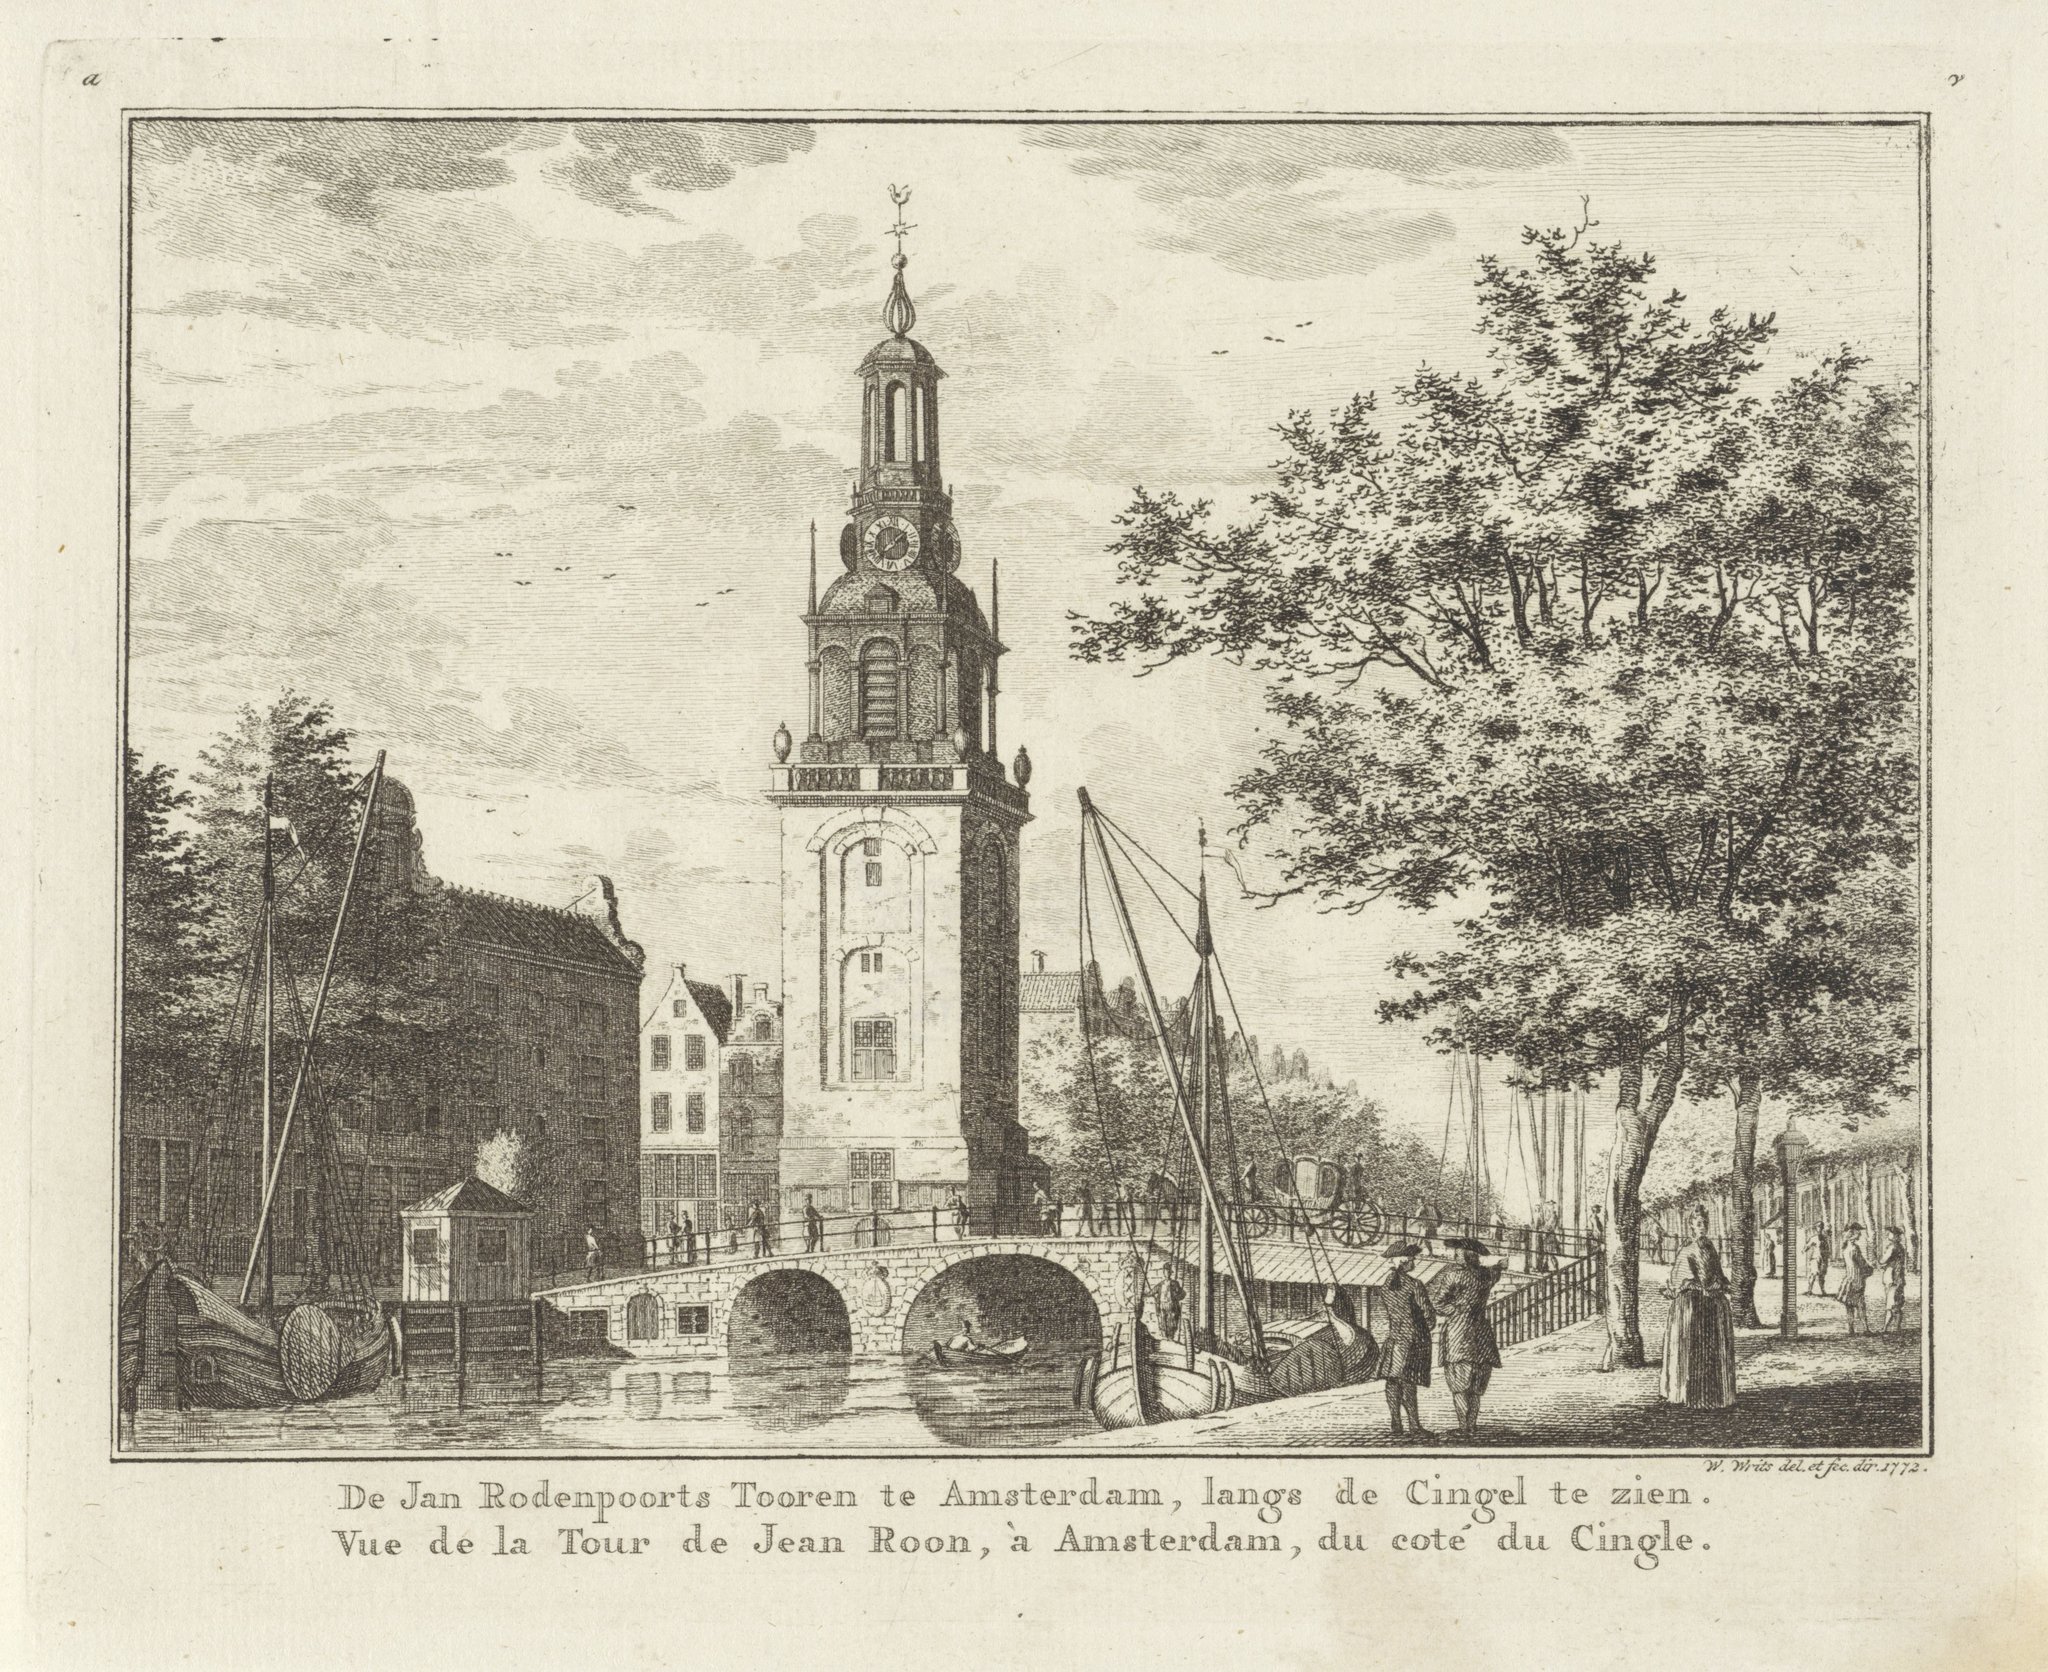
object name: print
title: Gezicht op de Jan Roodenpoortstoren te Amsterdam vanaf het Singel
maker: willem writs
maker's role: draughtsman, print maker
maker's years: 1731-1786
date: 1772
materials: paper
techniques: etching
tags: rowing-boat, canoe, etc.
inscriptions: collector's mark: Lugt 2228